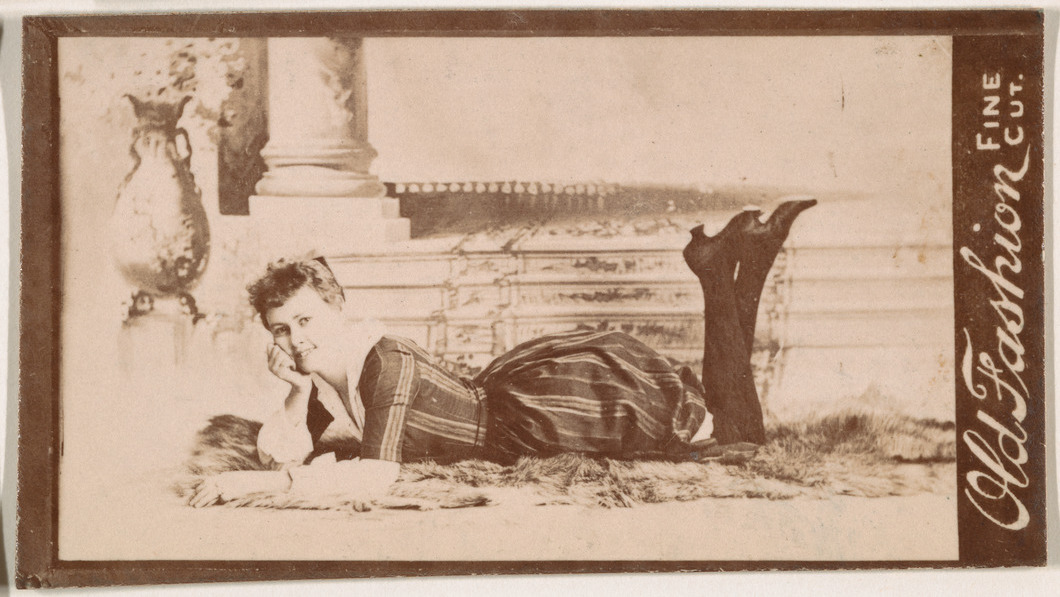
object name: photograph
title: Actress on fur rug, from the Actresses series (N664) promoting Old Fashion Fine Cut Tobacco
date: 1888-1890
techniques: albumen silver print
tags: portraits,women,actresses